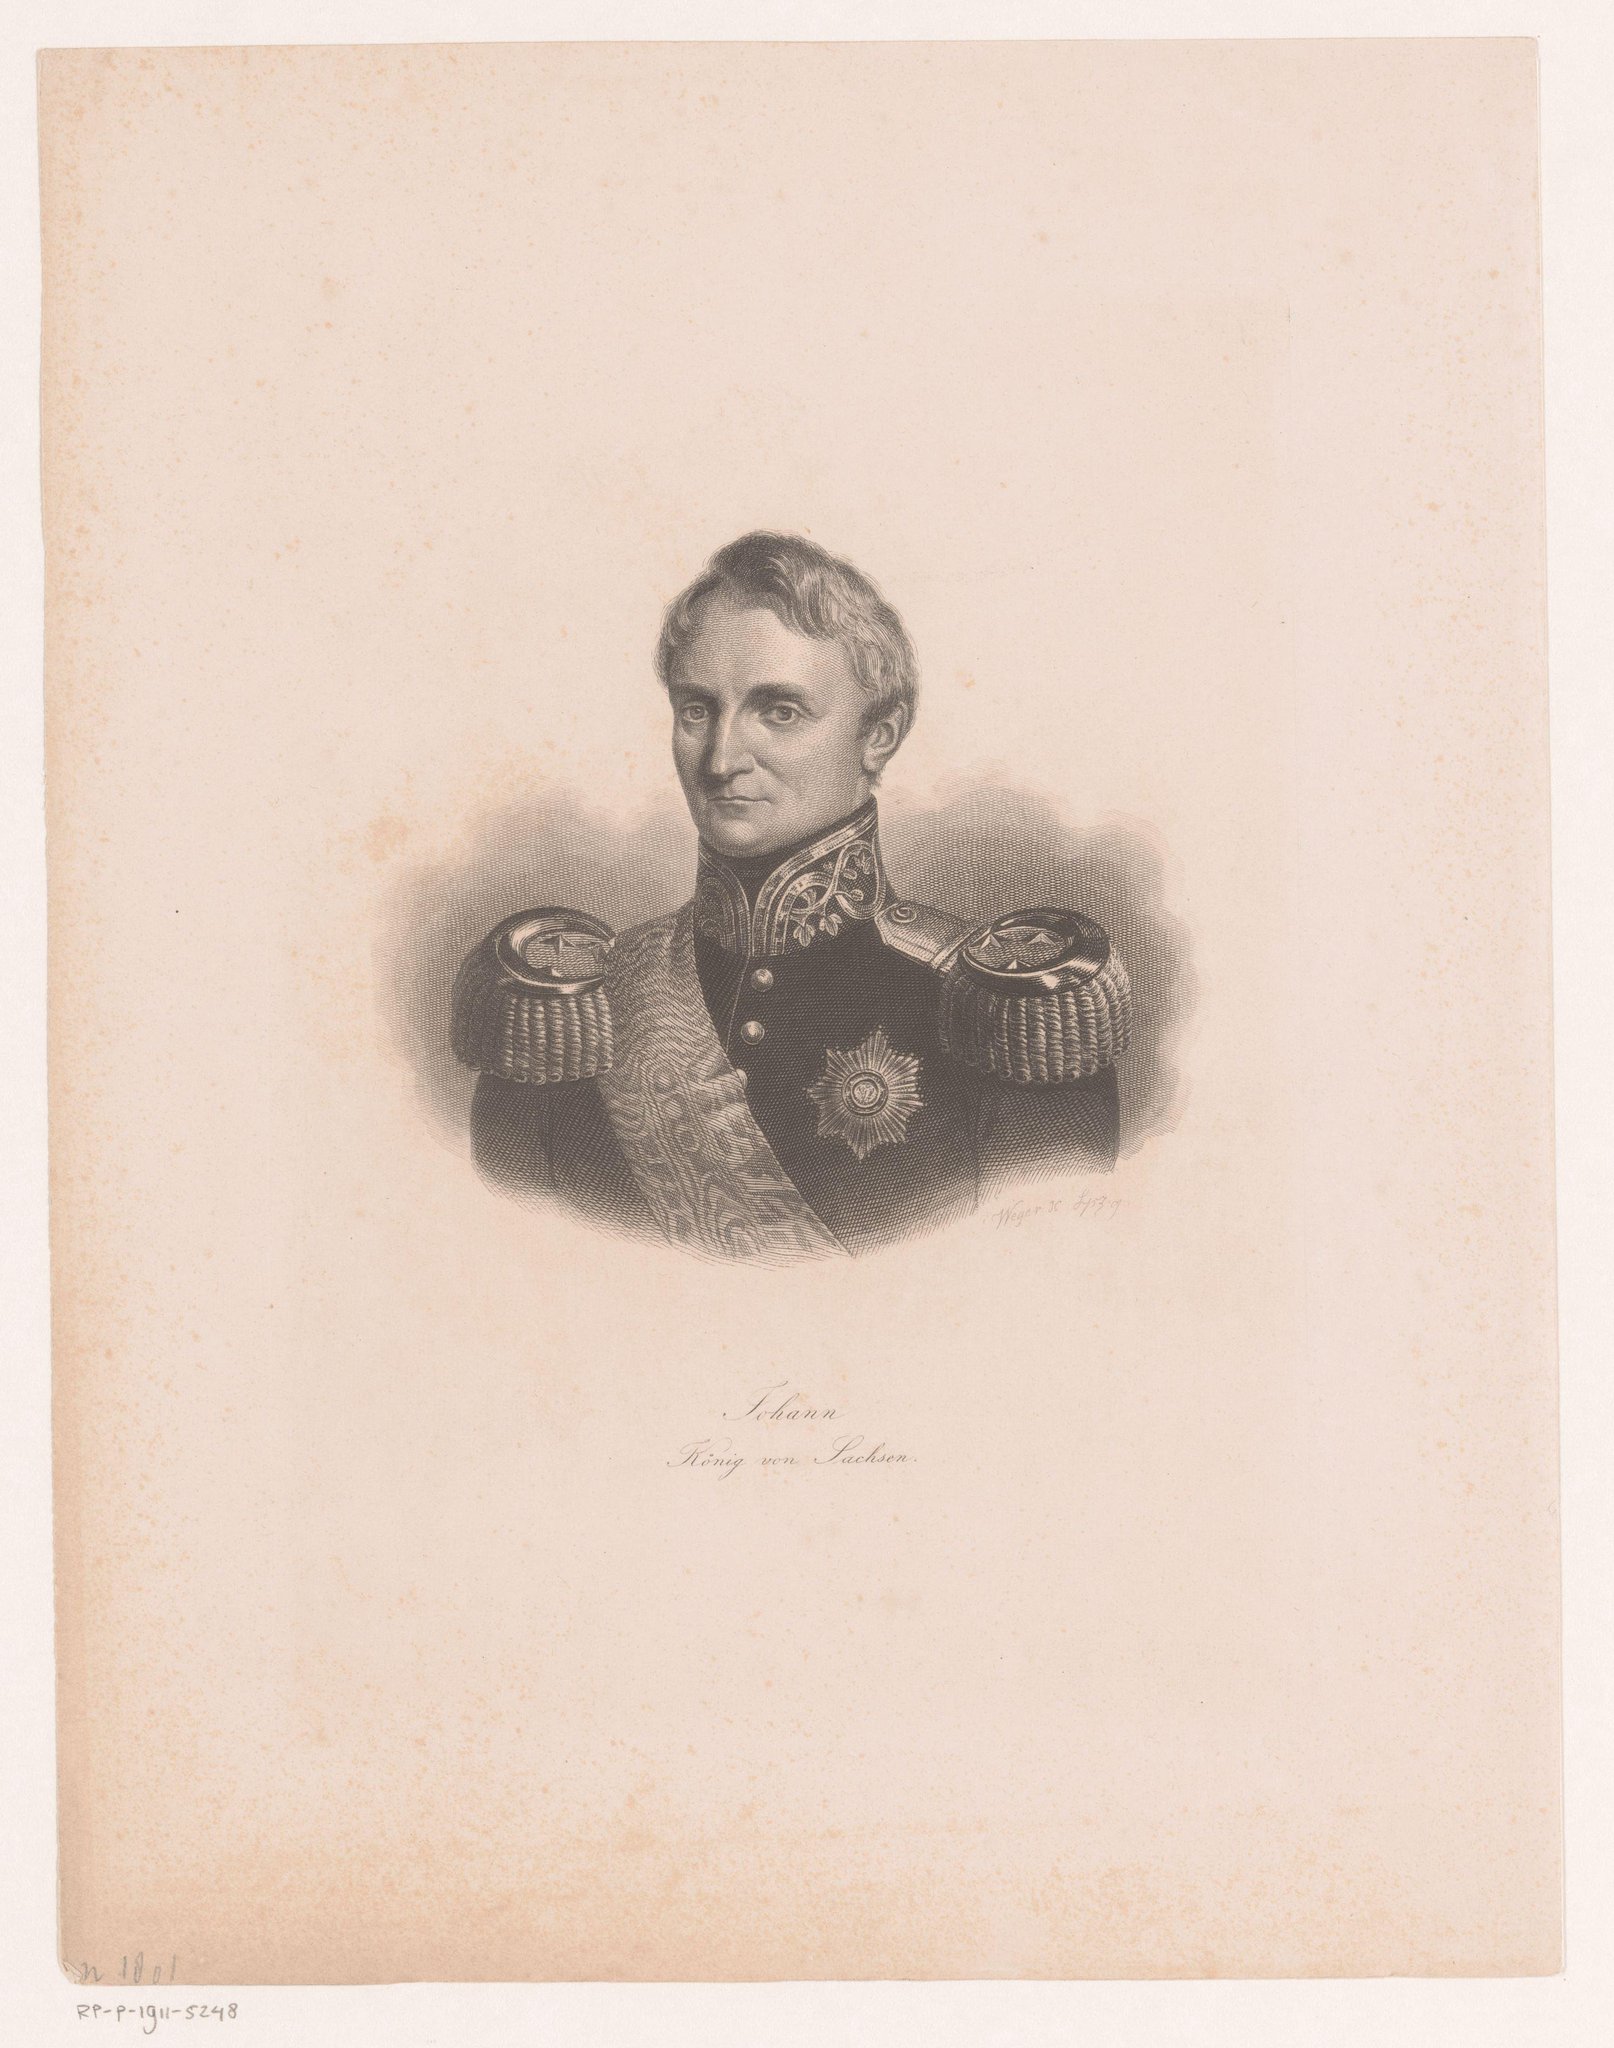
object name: print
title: Portret van Johann, koning van Saksen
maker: august weger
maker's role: print maker, printer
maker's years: 1823-1892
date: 1849-1892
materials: paper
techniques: engraving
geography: leipzig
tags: historical persons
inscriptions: collector's mark: Lugt 2228